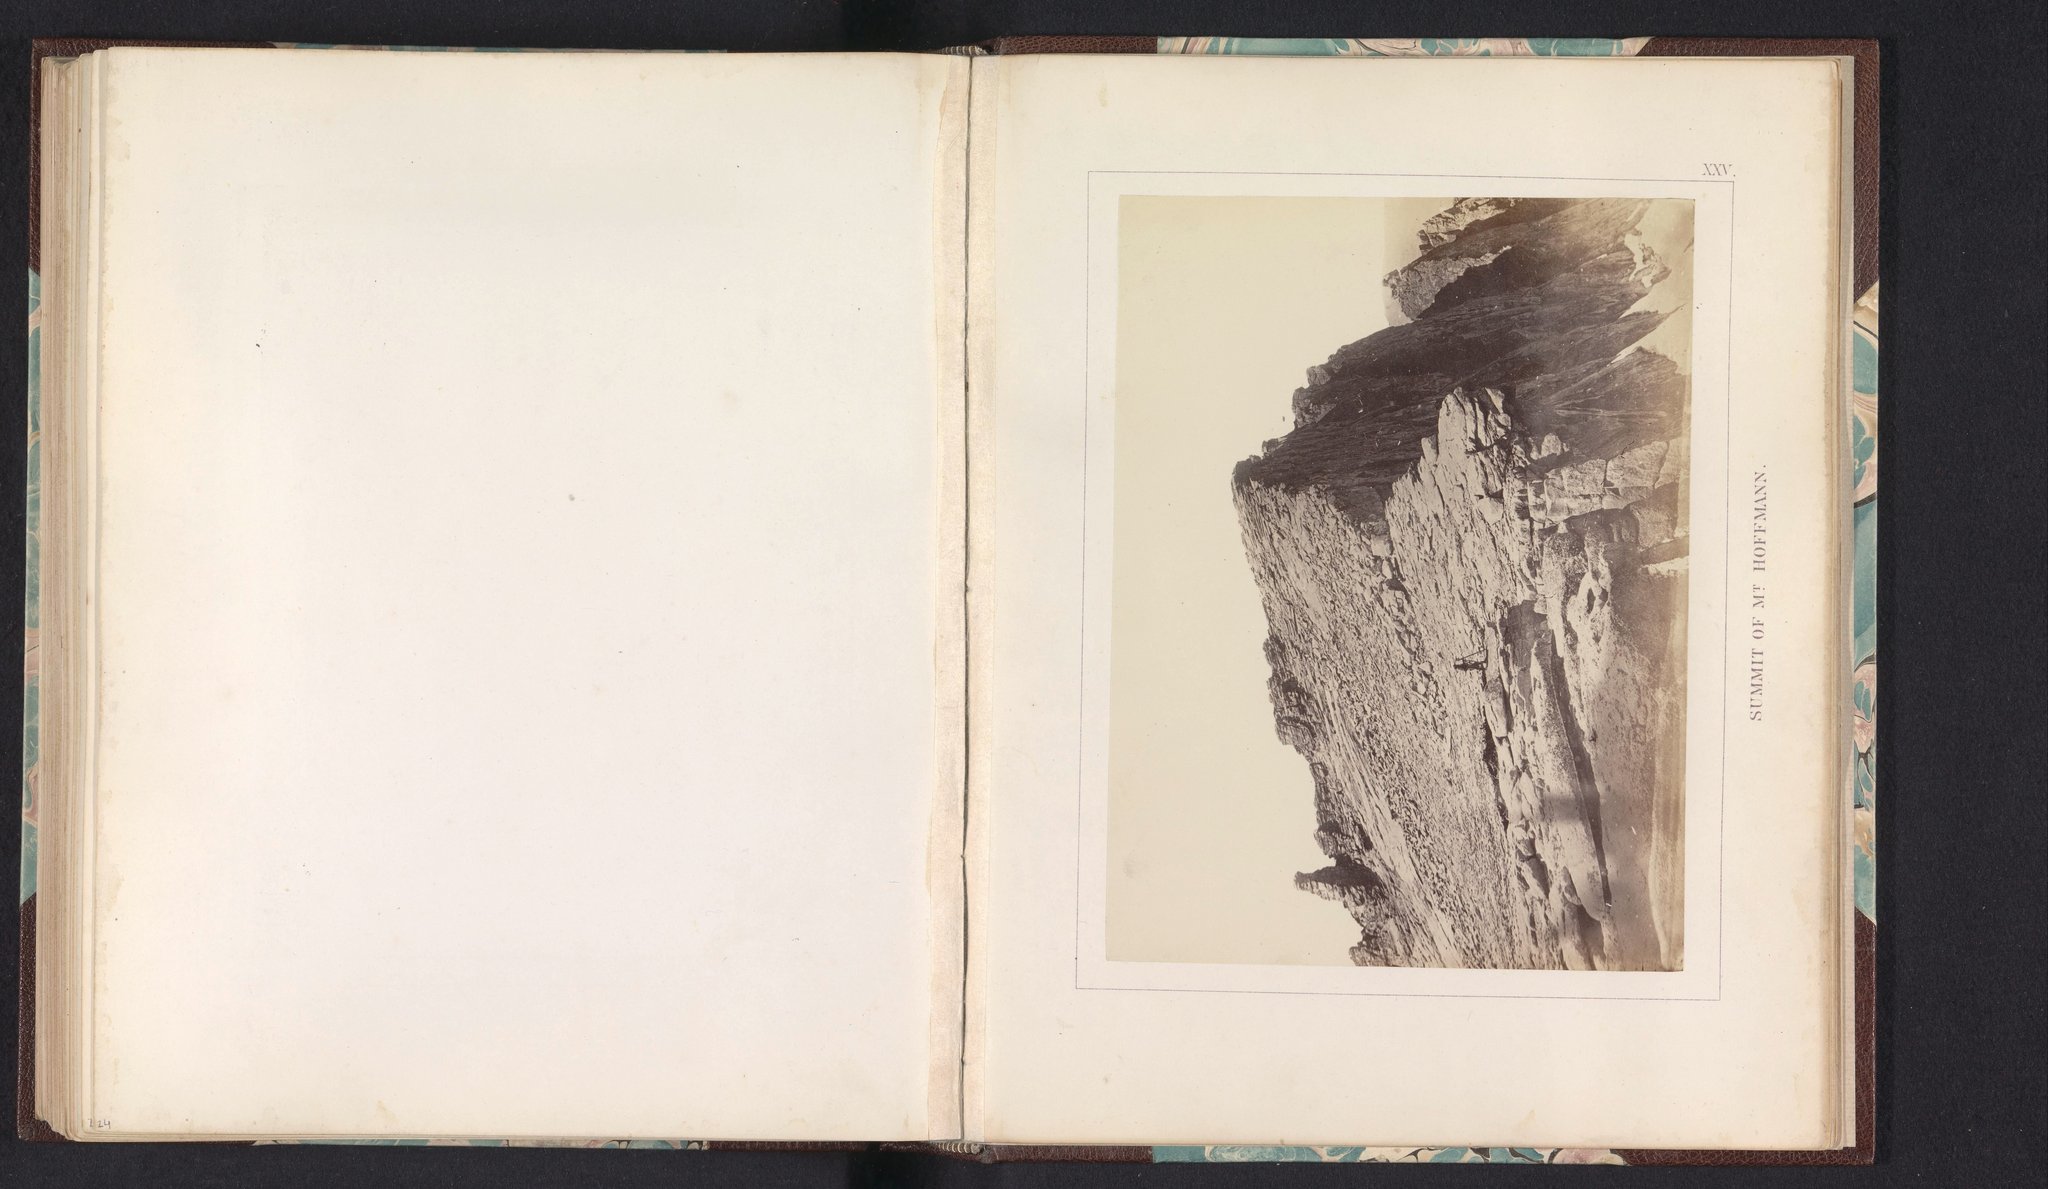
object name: page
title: Gezicht op top van Mount Hoffmann in de Yosemite Valley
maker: w. harris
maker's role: fotograaf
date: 1860-1868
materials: photographic support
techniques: albumen print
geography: yosemite valley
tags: mountain-top, peak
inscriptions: number: ‘XXV.’